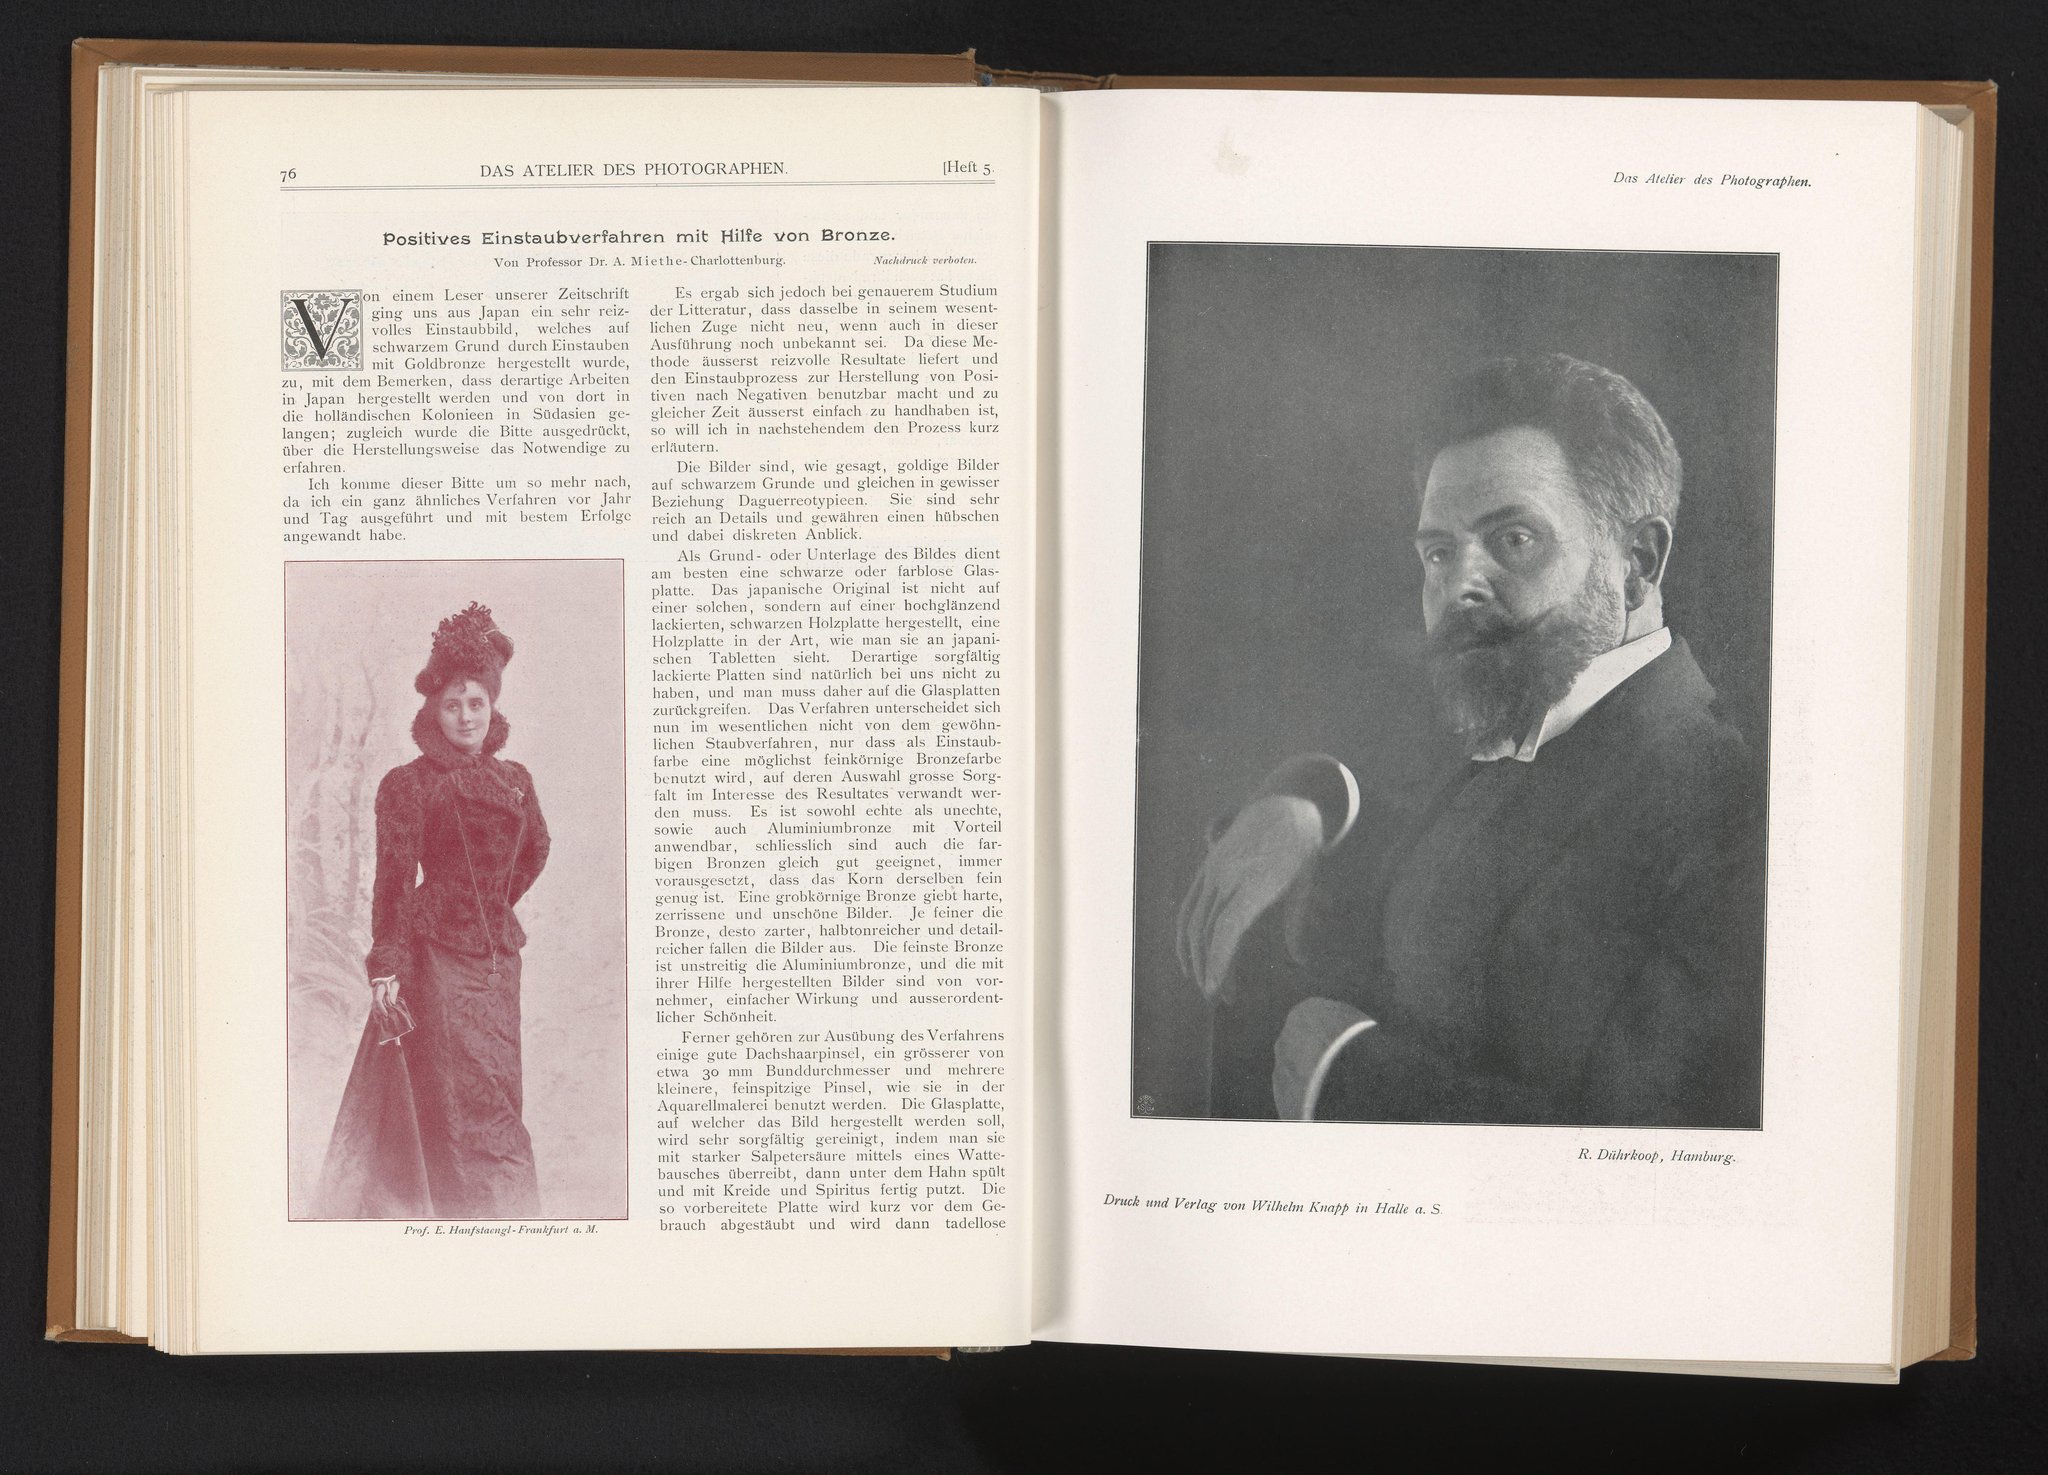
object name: photomechanical print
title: Portret van een onbekende man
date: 1895-1900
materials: paper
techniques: autotype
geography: halle an der saale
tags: historical persons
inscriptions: inscription: ‘Das Atelier des Photographen.’, monogram: ‘LEIPZIG/ S G’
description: Prent op derde ongenummerde pagina na pagina 76.